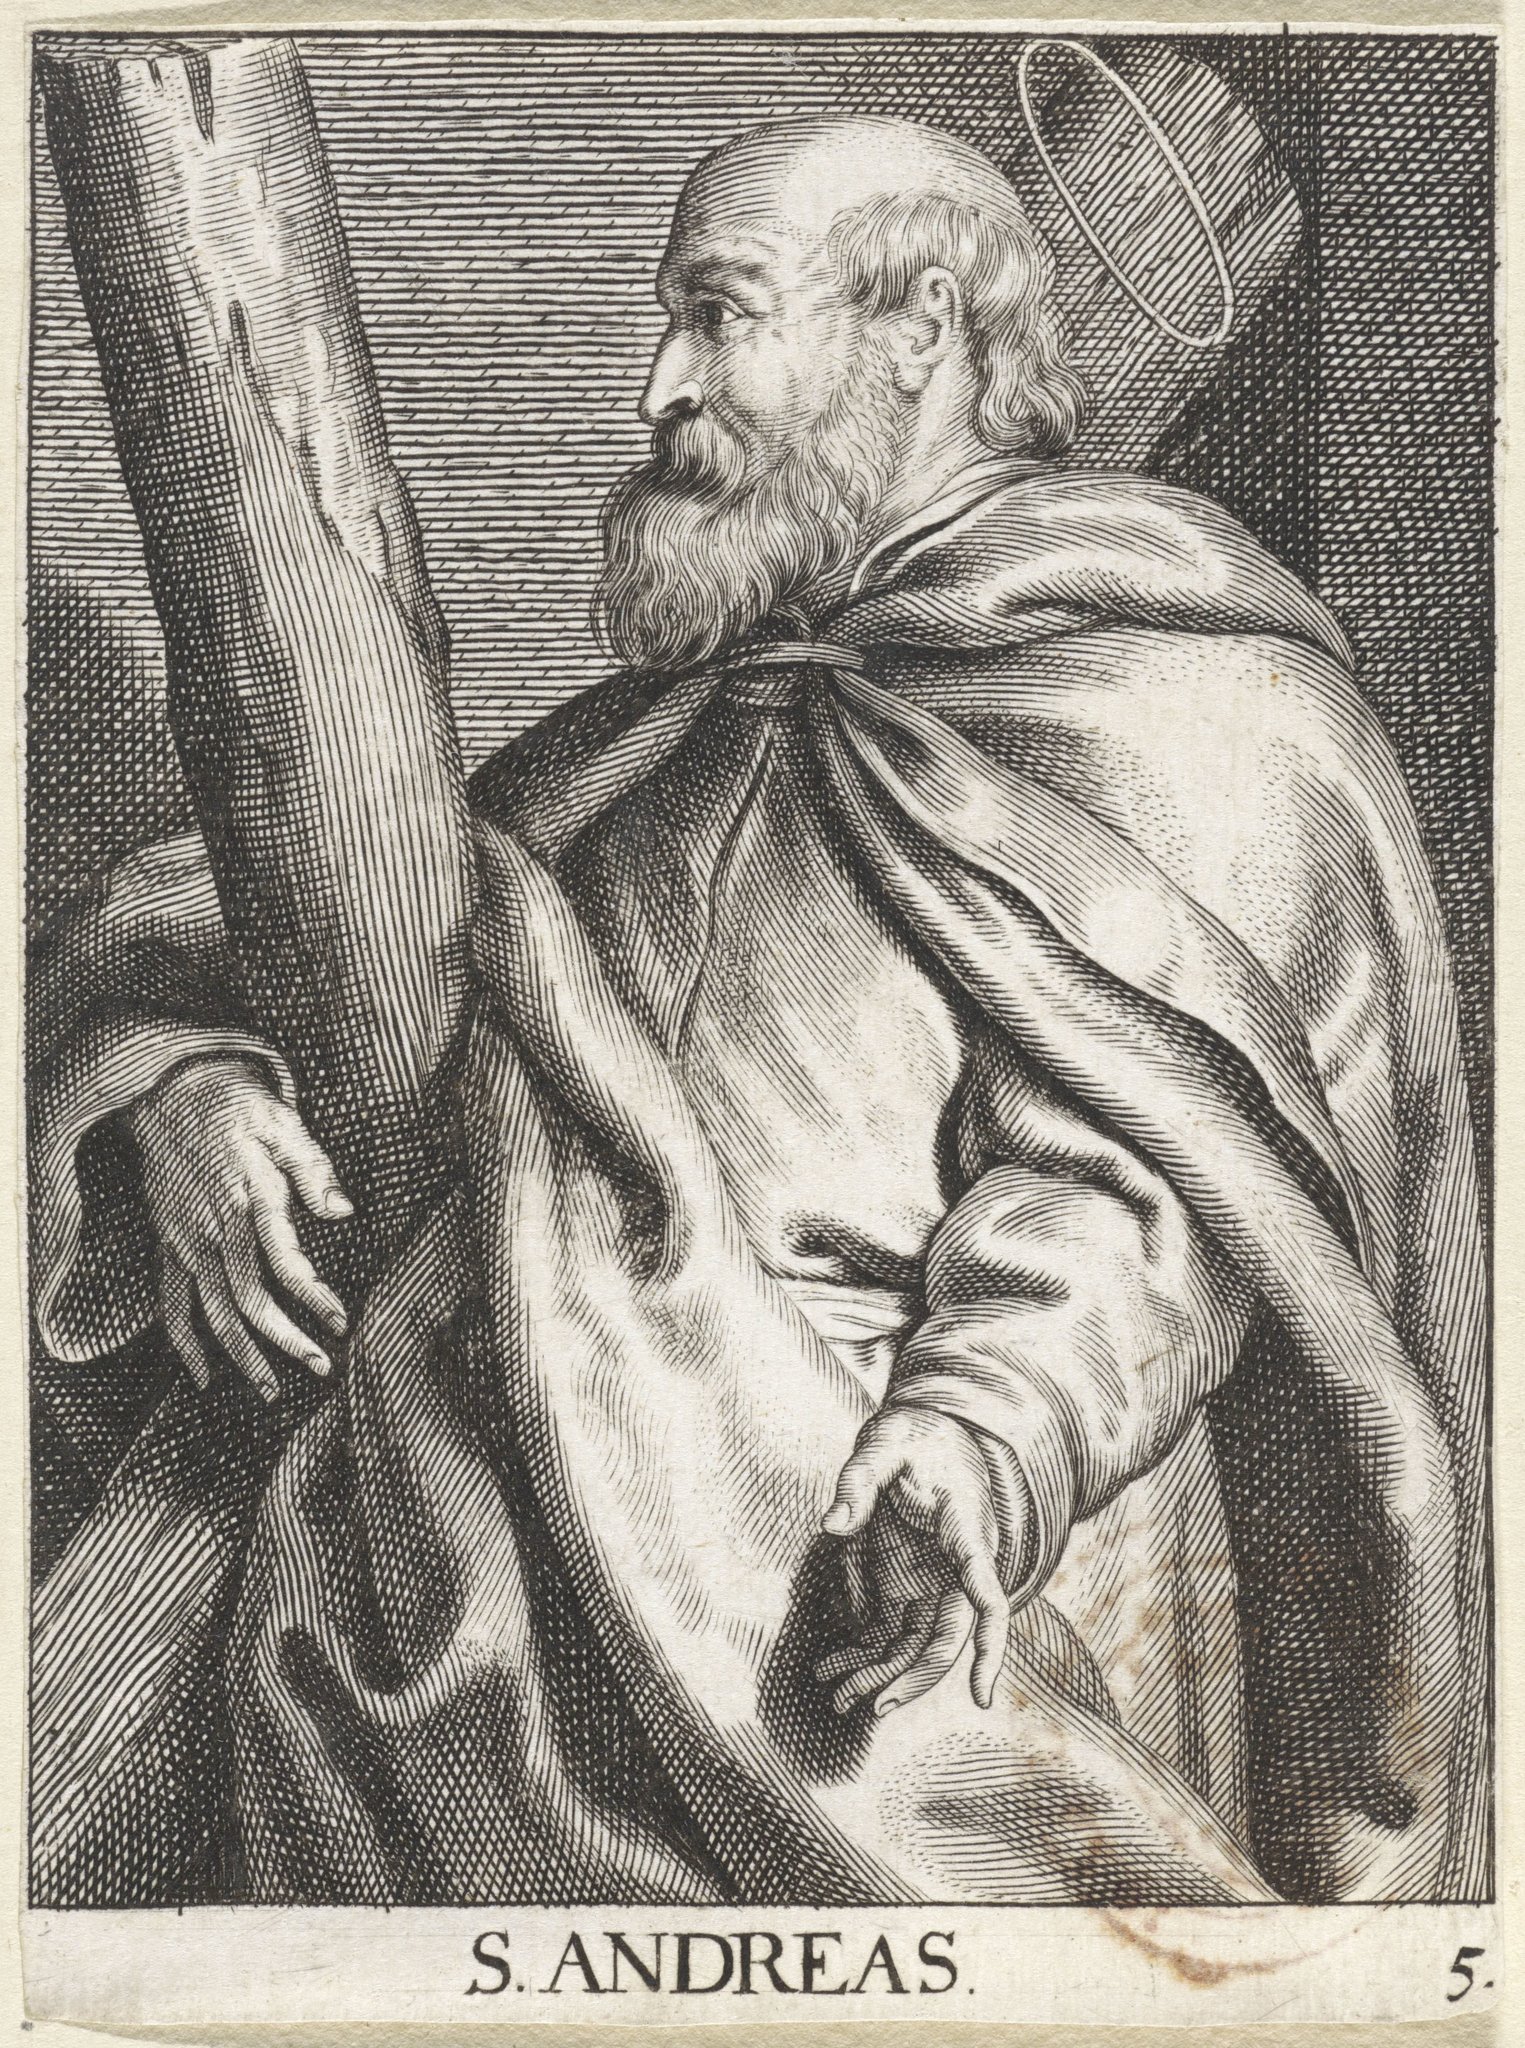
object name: print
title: S. Andreas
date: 1637-1666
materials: paper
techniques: engraving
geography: nuremberg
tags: the apostle andrew; possible attributes: book, x-shaped cross, fish, fishing-net, rope, scroll - portrait of male saint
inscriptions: collector's mark: Lugt 240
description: De apostel Andreas staat voor een muur. Hij heeft het x-vormige kruis waarop hij gekruisigd werd, het Andreaskruis, onder zijn arm.